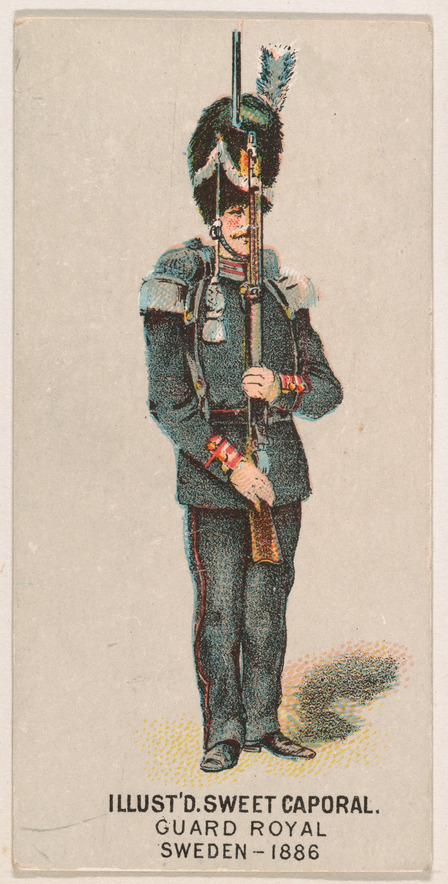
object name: print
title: Royal Guard, Sweden, 1886, from the Military Series (N224) issued by Kinney Tobacco Company to promote Sweet Caporal Cigarettes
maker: kinney brothers tobacco company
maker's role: publisher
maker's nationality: american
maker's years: 1869-2011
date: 1888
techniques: color lithograph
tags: military,firearms,men